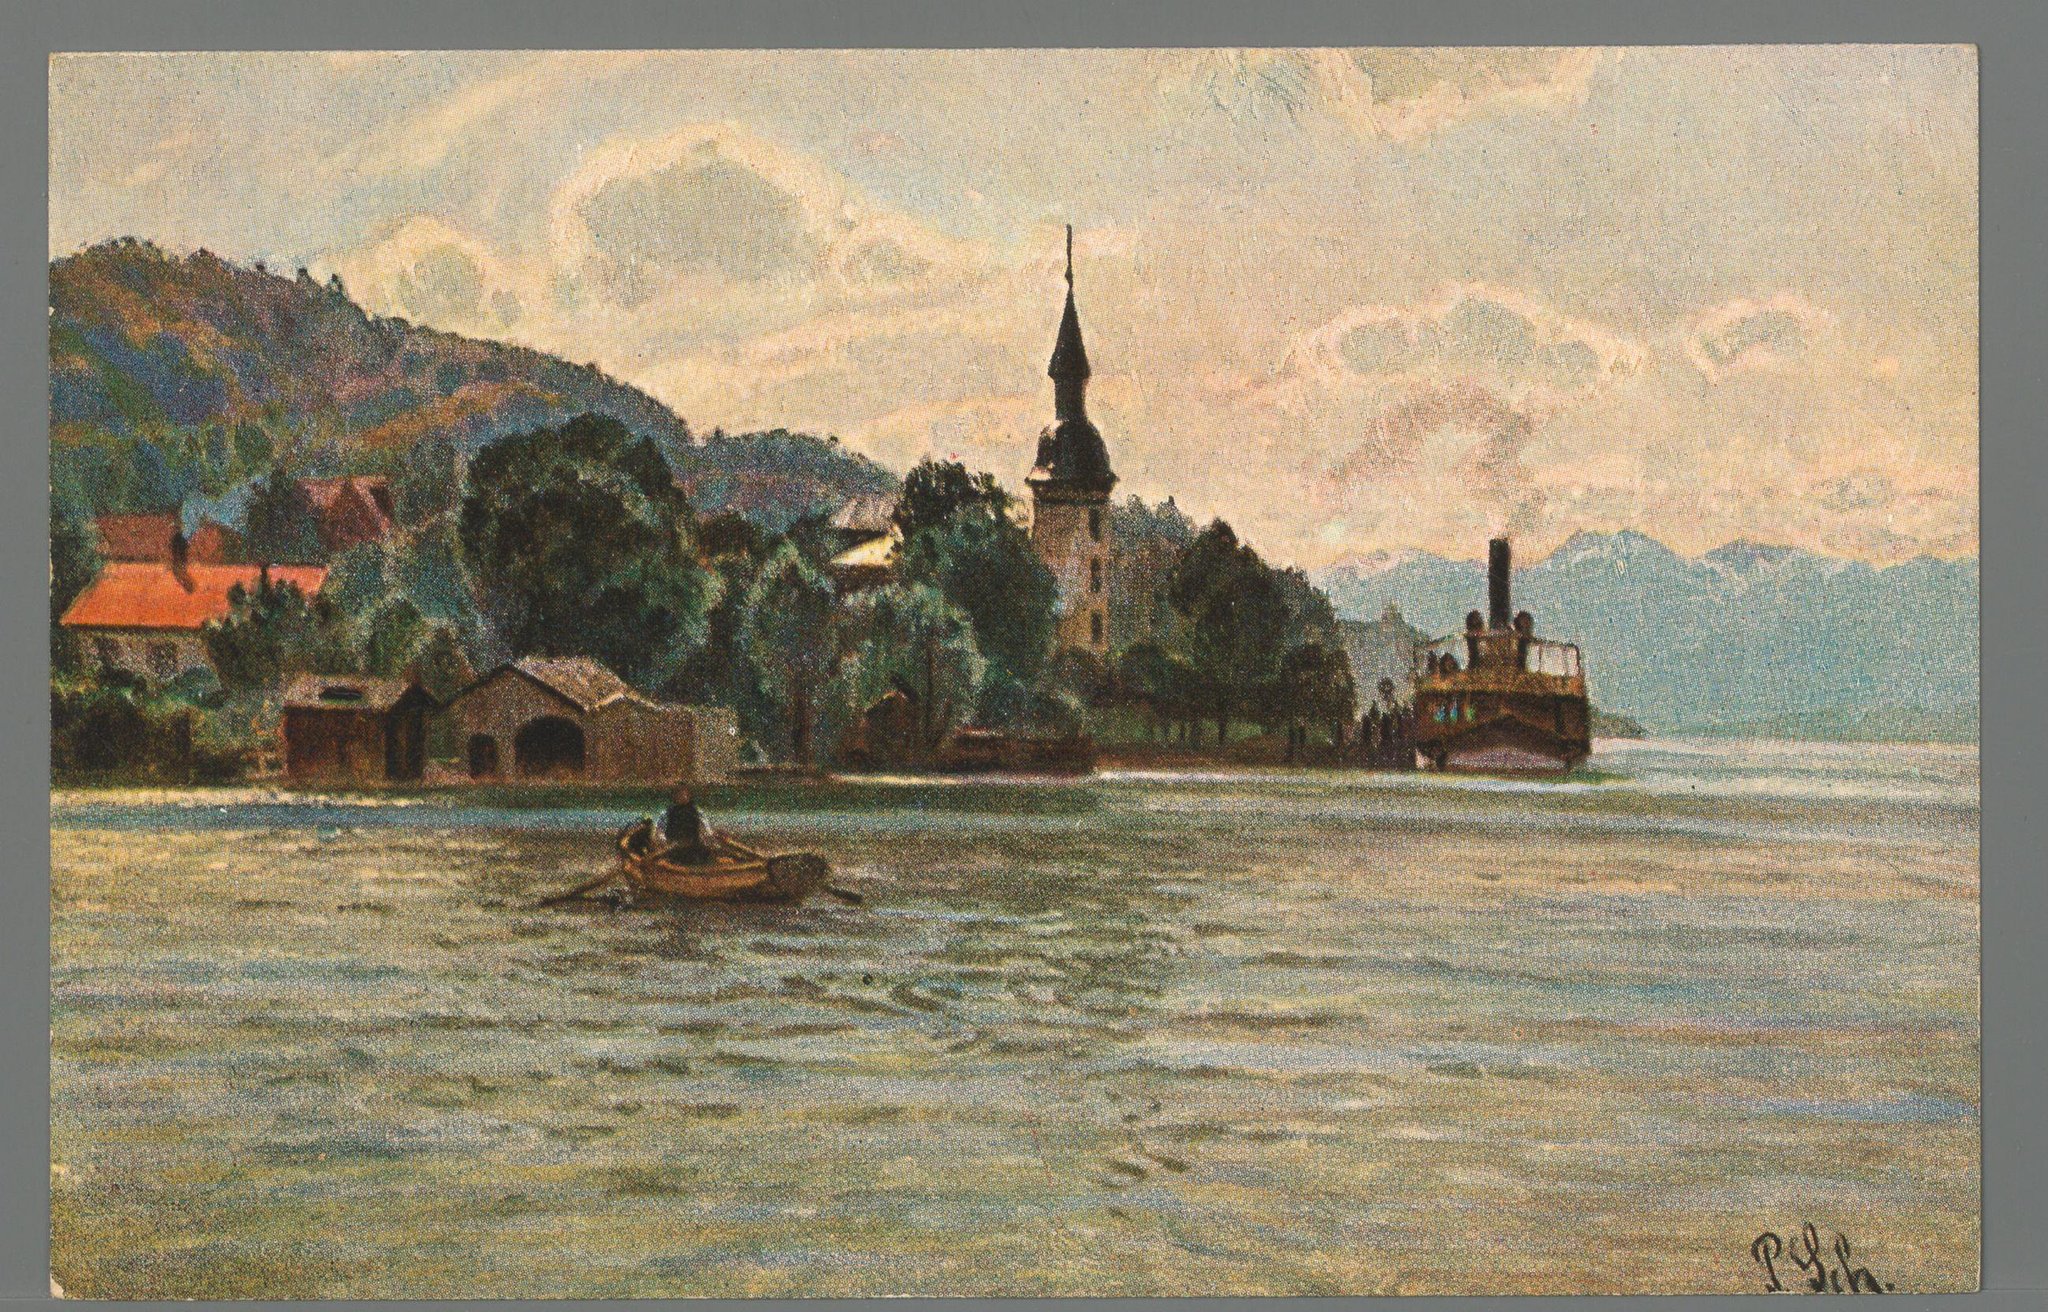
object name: reproduction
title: Leoni. Starnbergersee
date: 1905-1909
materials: cardboard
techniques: writing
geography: munich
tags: lake, steamship, motorship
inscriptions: inscription: ‘P. Sch.’